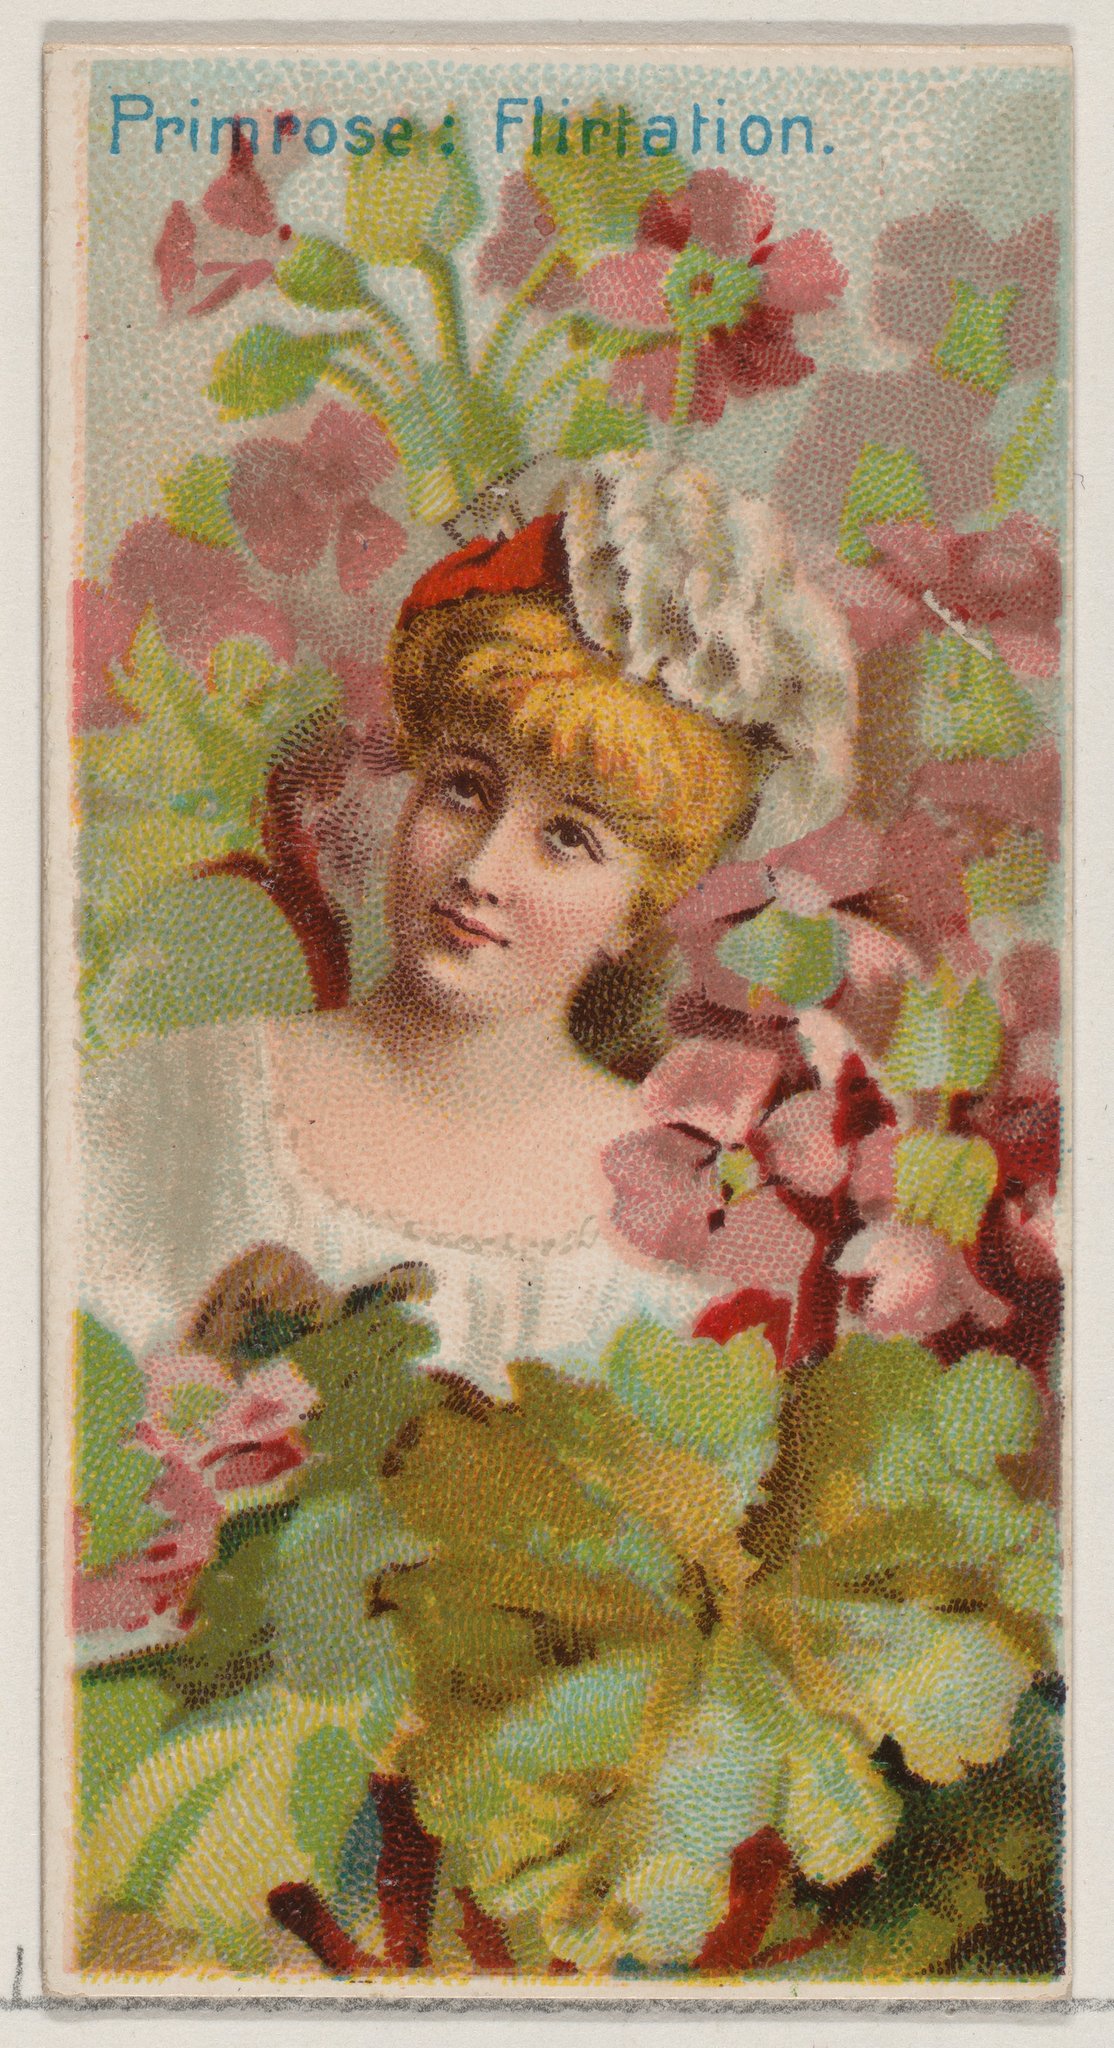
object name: print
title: Primrose: Flirtation, from the series Floral Beauties and Language of Flowers (N75) for Duke brand cigarettes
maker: american tobacco company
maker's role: publisher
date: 1892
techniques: color lithograph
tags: women,flowers